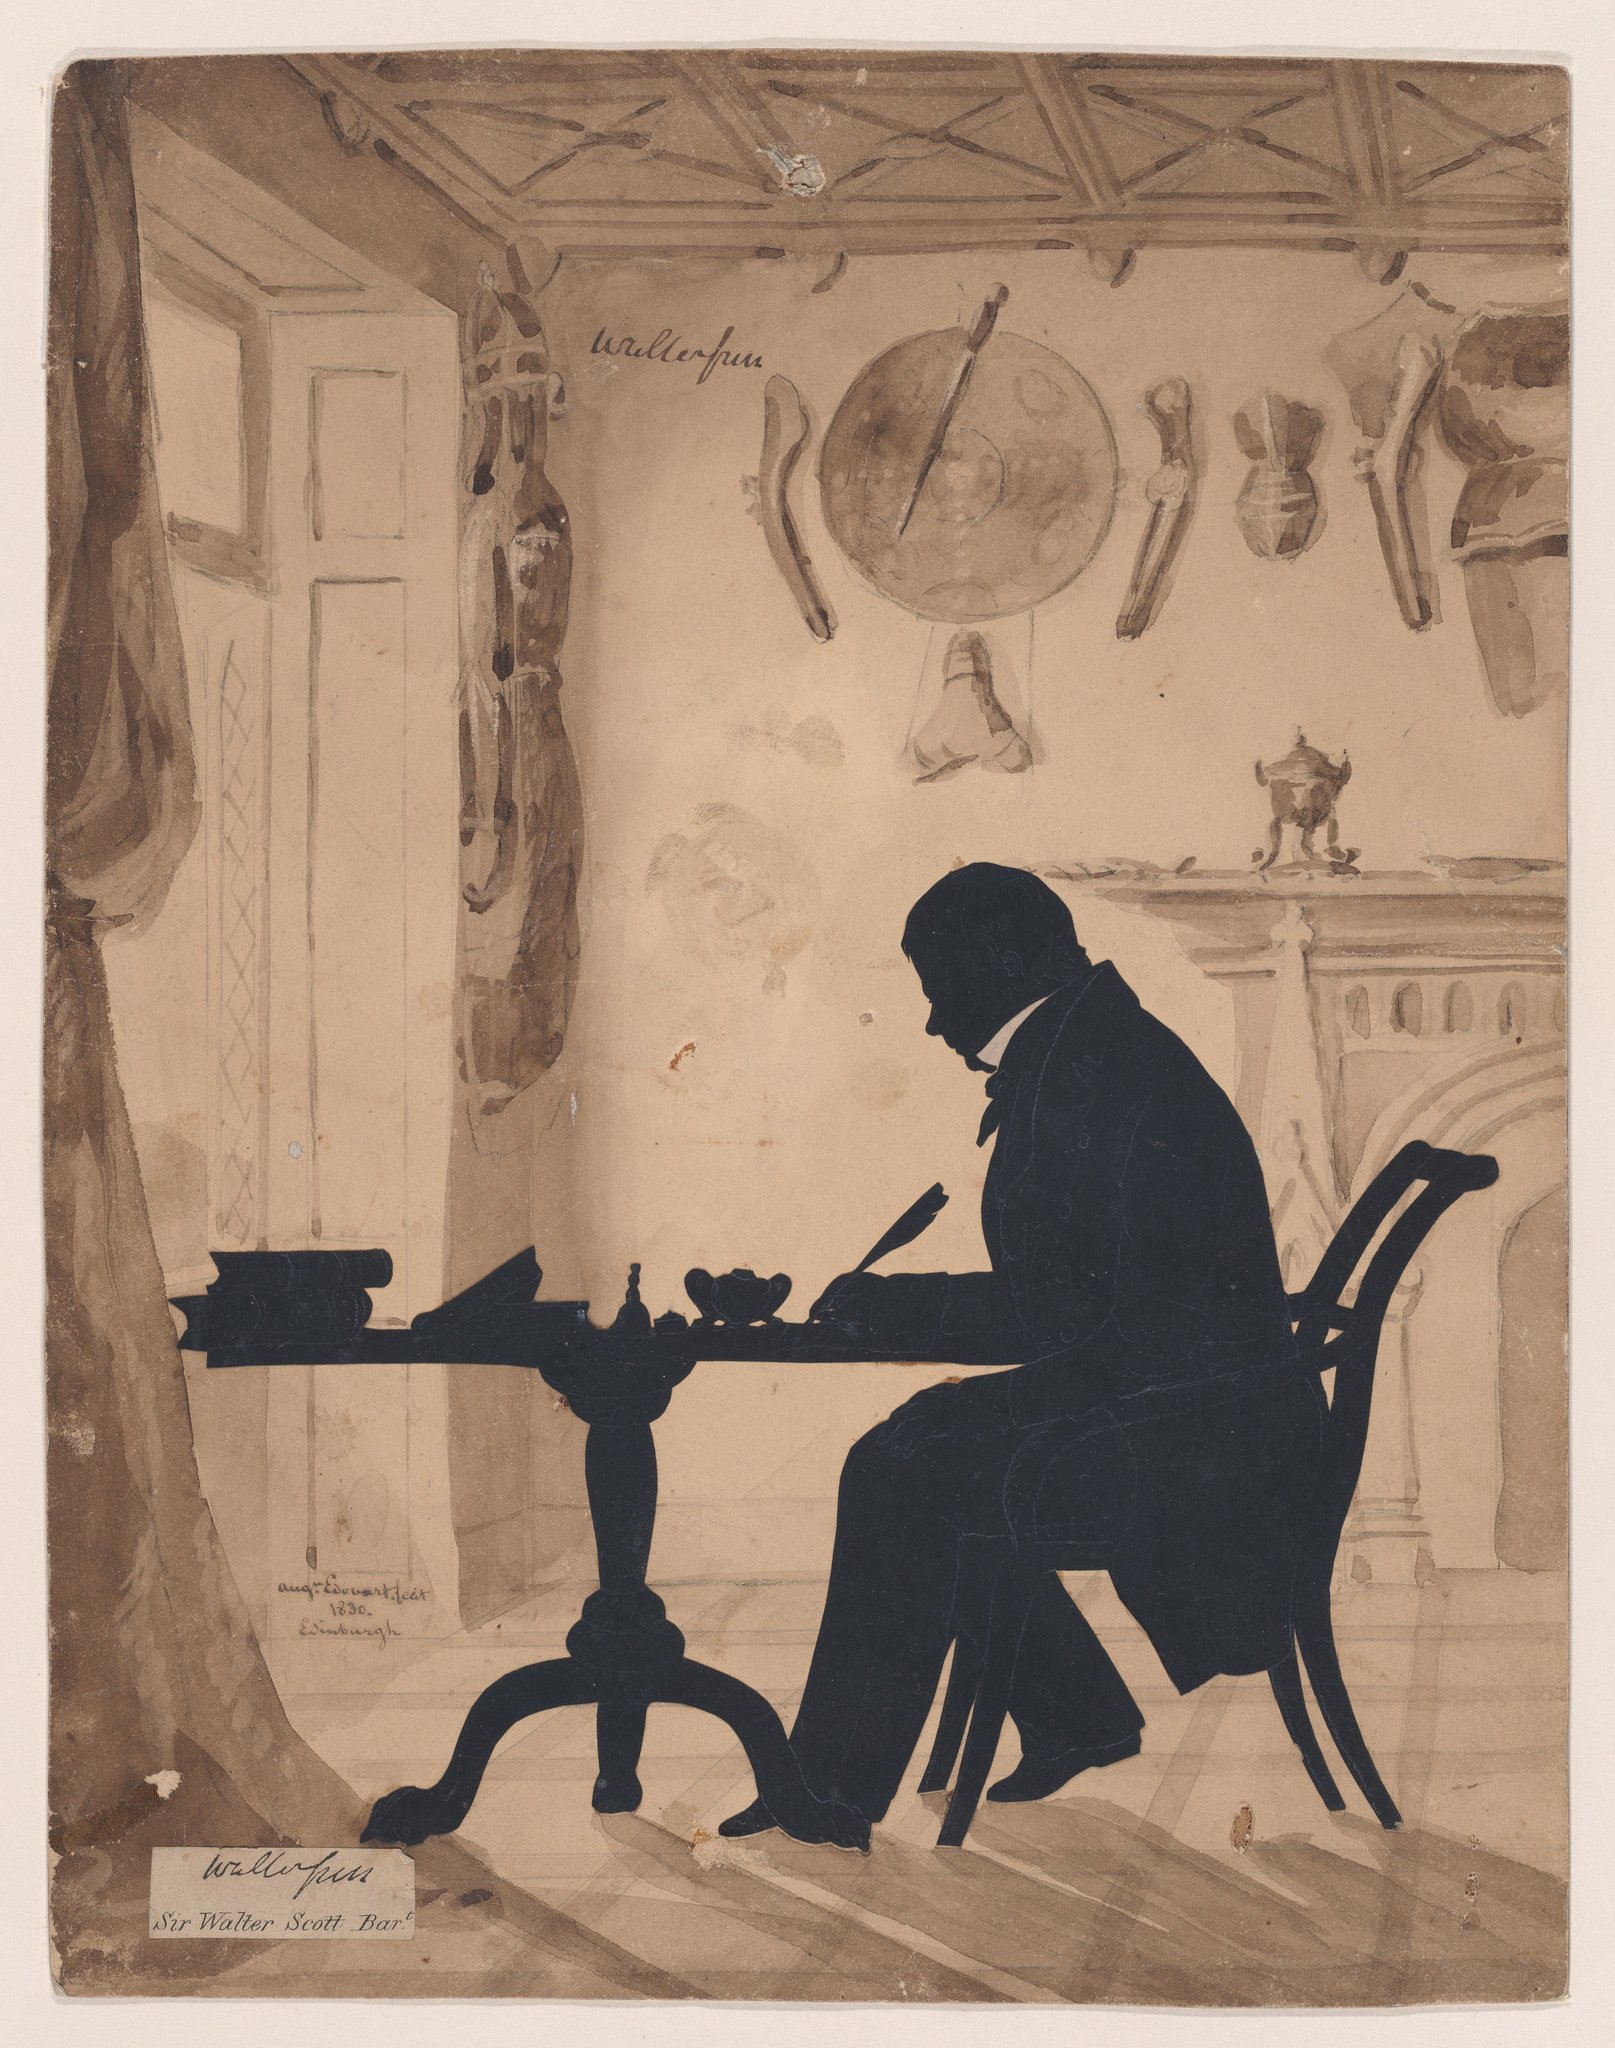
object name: cut paper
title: Sir Walter Scott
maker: auguste edouart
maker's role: artist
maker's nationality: french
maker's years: 1789-1861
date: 1830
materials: paper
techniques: brush, cutting, wash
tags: men,writing,tables